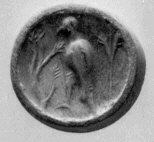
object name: stamp seal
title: Discoid seal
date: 1400-1301 BCE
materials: quartz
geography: cyprus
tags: birds